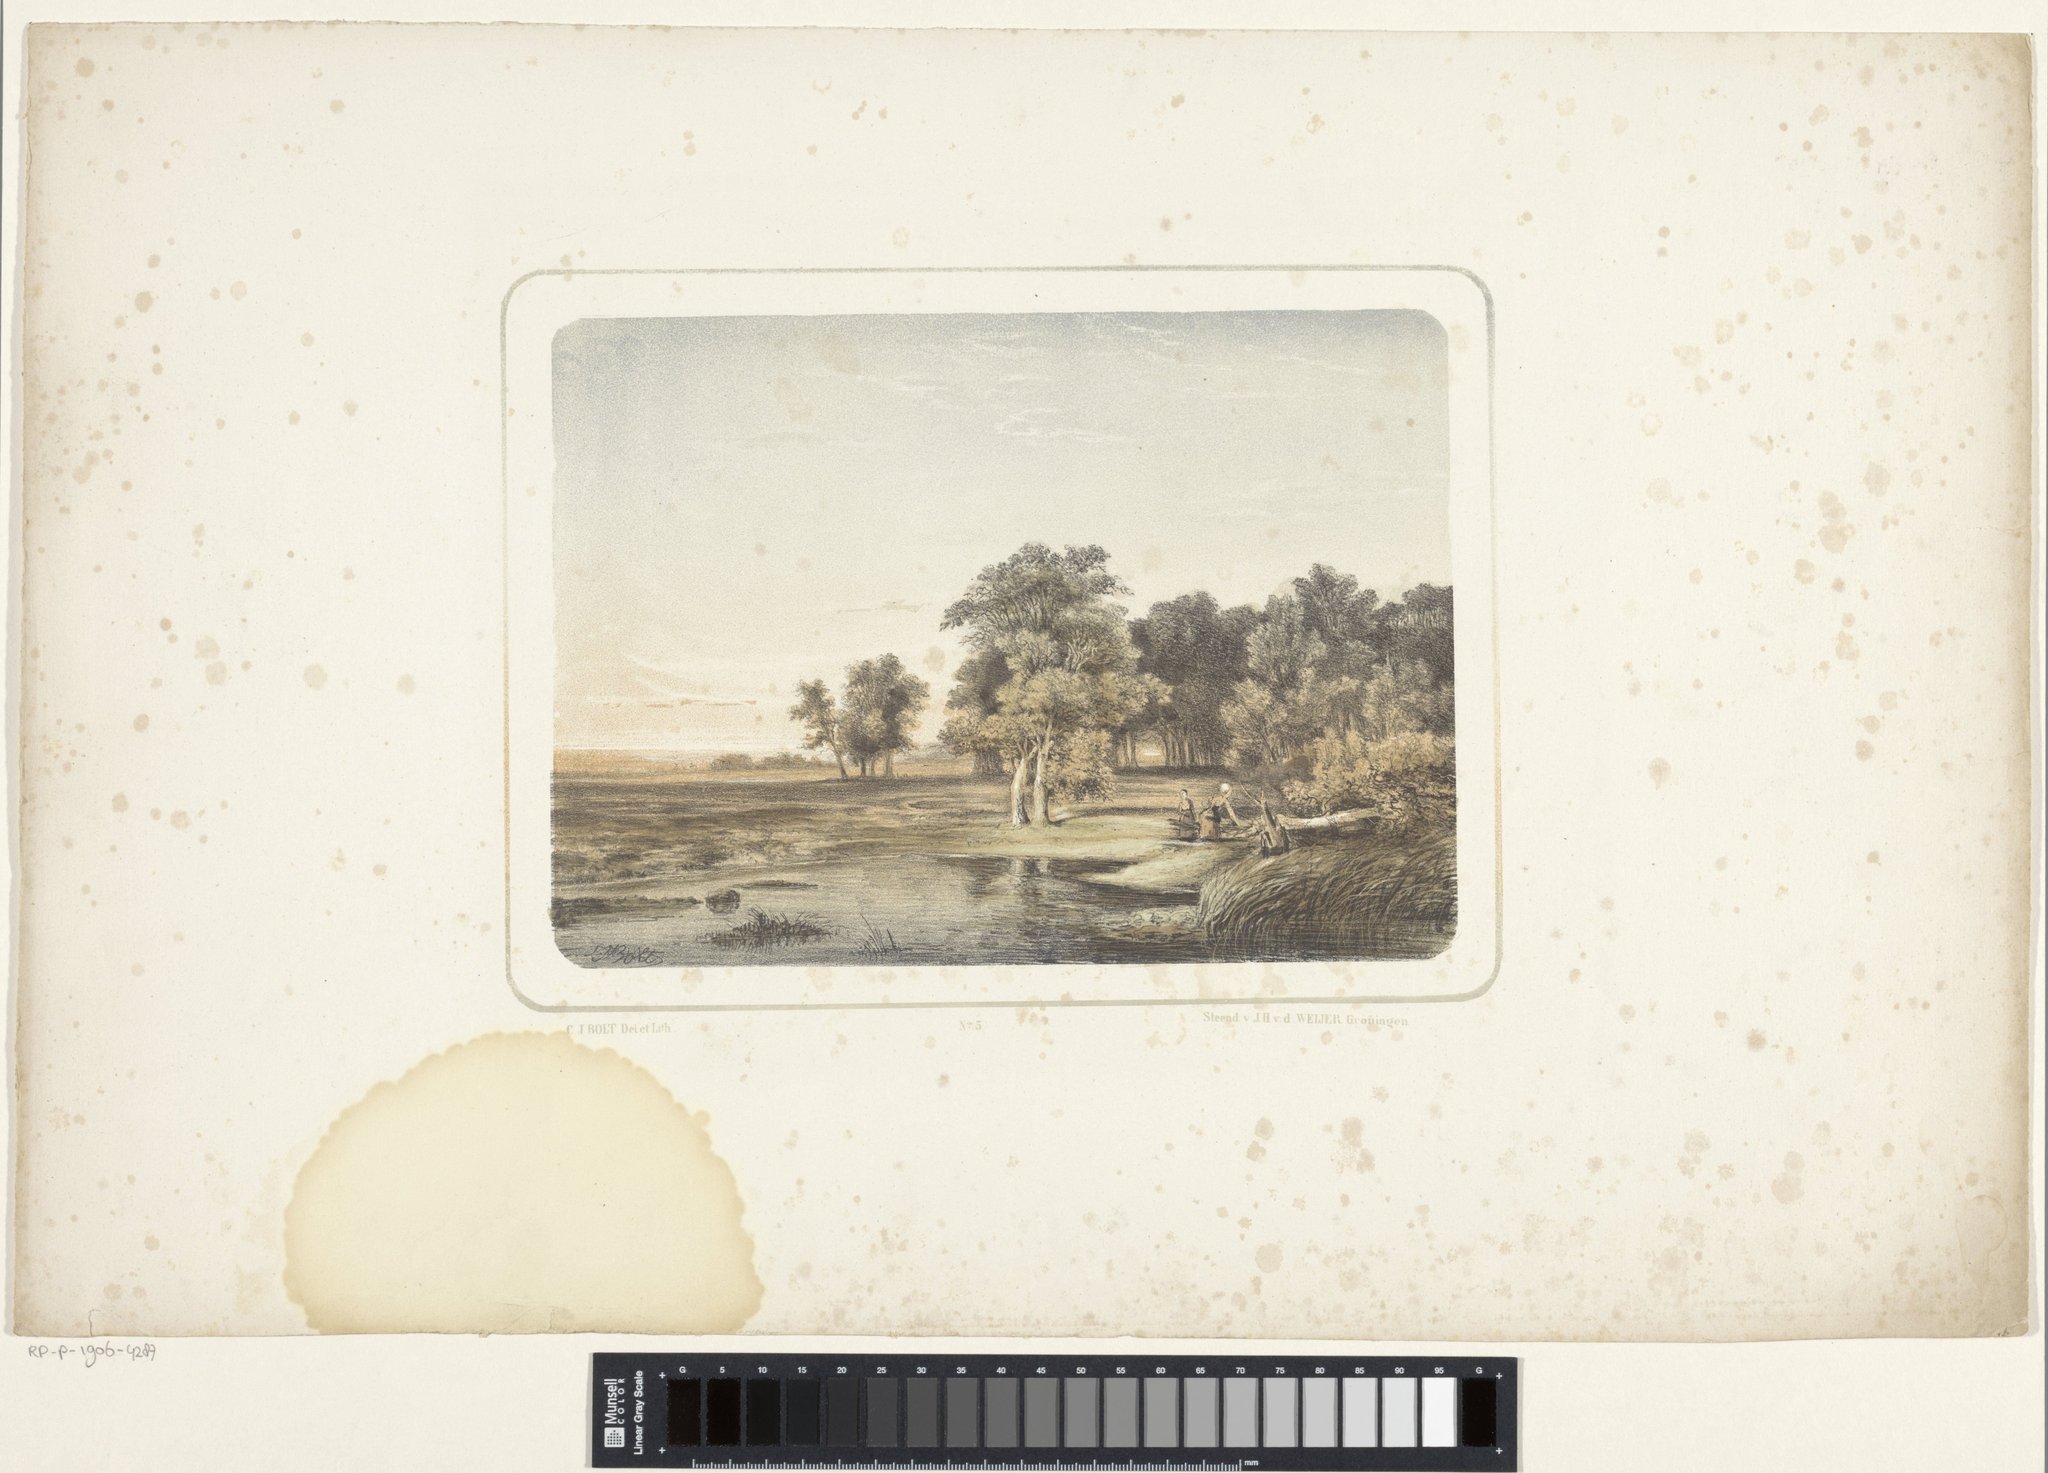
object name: print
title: Zes landschappen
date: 1833-1879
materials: paper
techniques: lithograph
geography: groningen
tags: woodcutting, woodcutter ~ forestry, landscapes in the temperate zone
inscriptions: collector's mark: Lugt 2228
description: Aan het water zijn twee vrouwen in de weer met een omgevallen boom. Rechts een bos. Onder de afbeelding: no. 5.